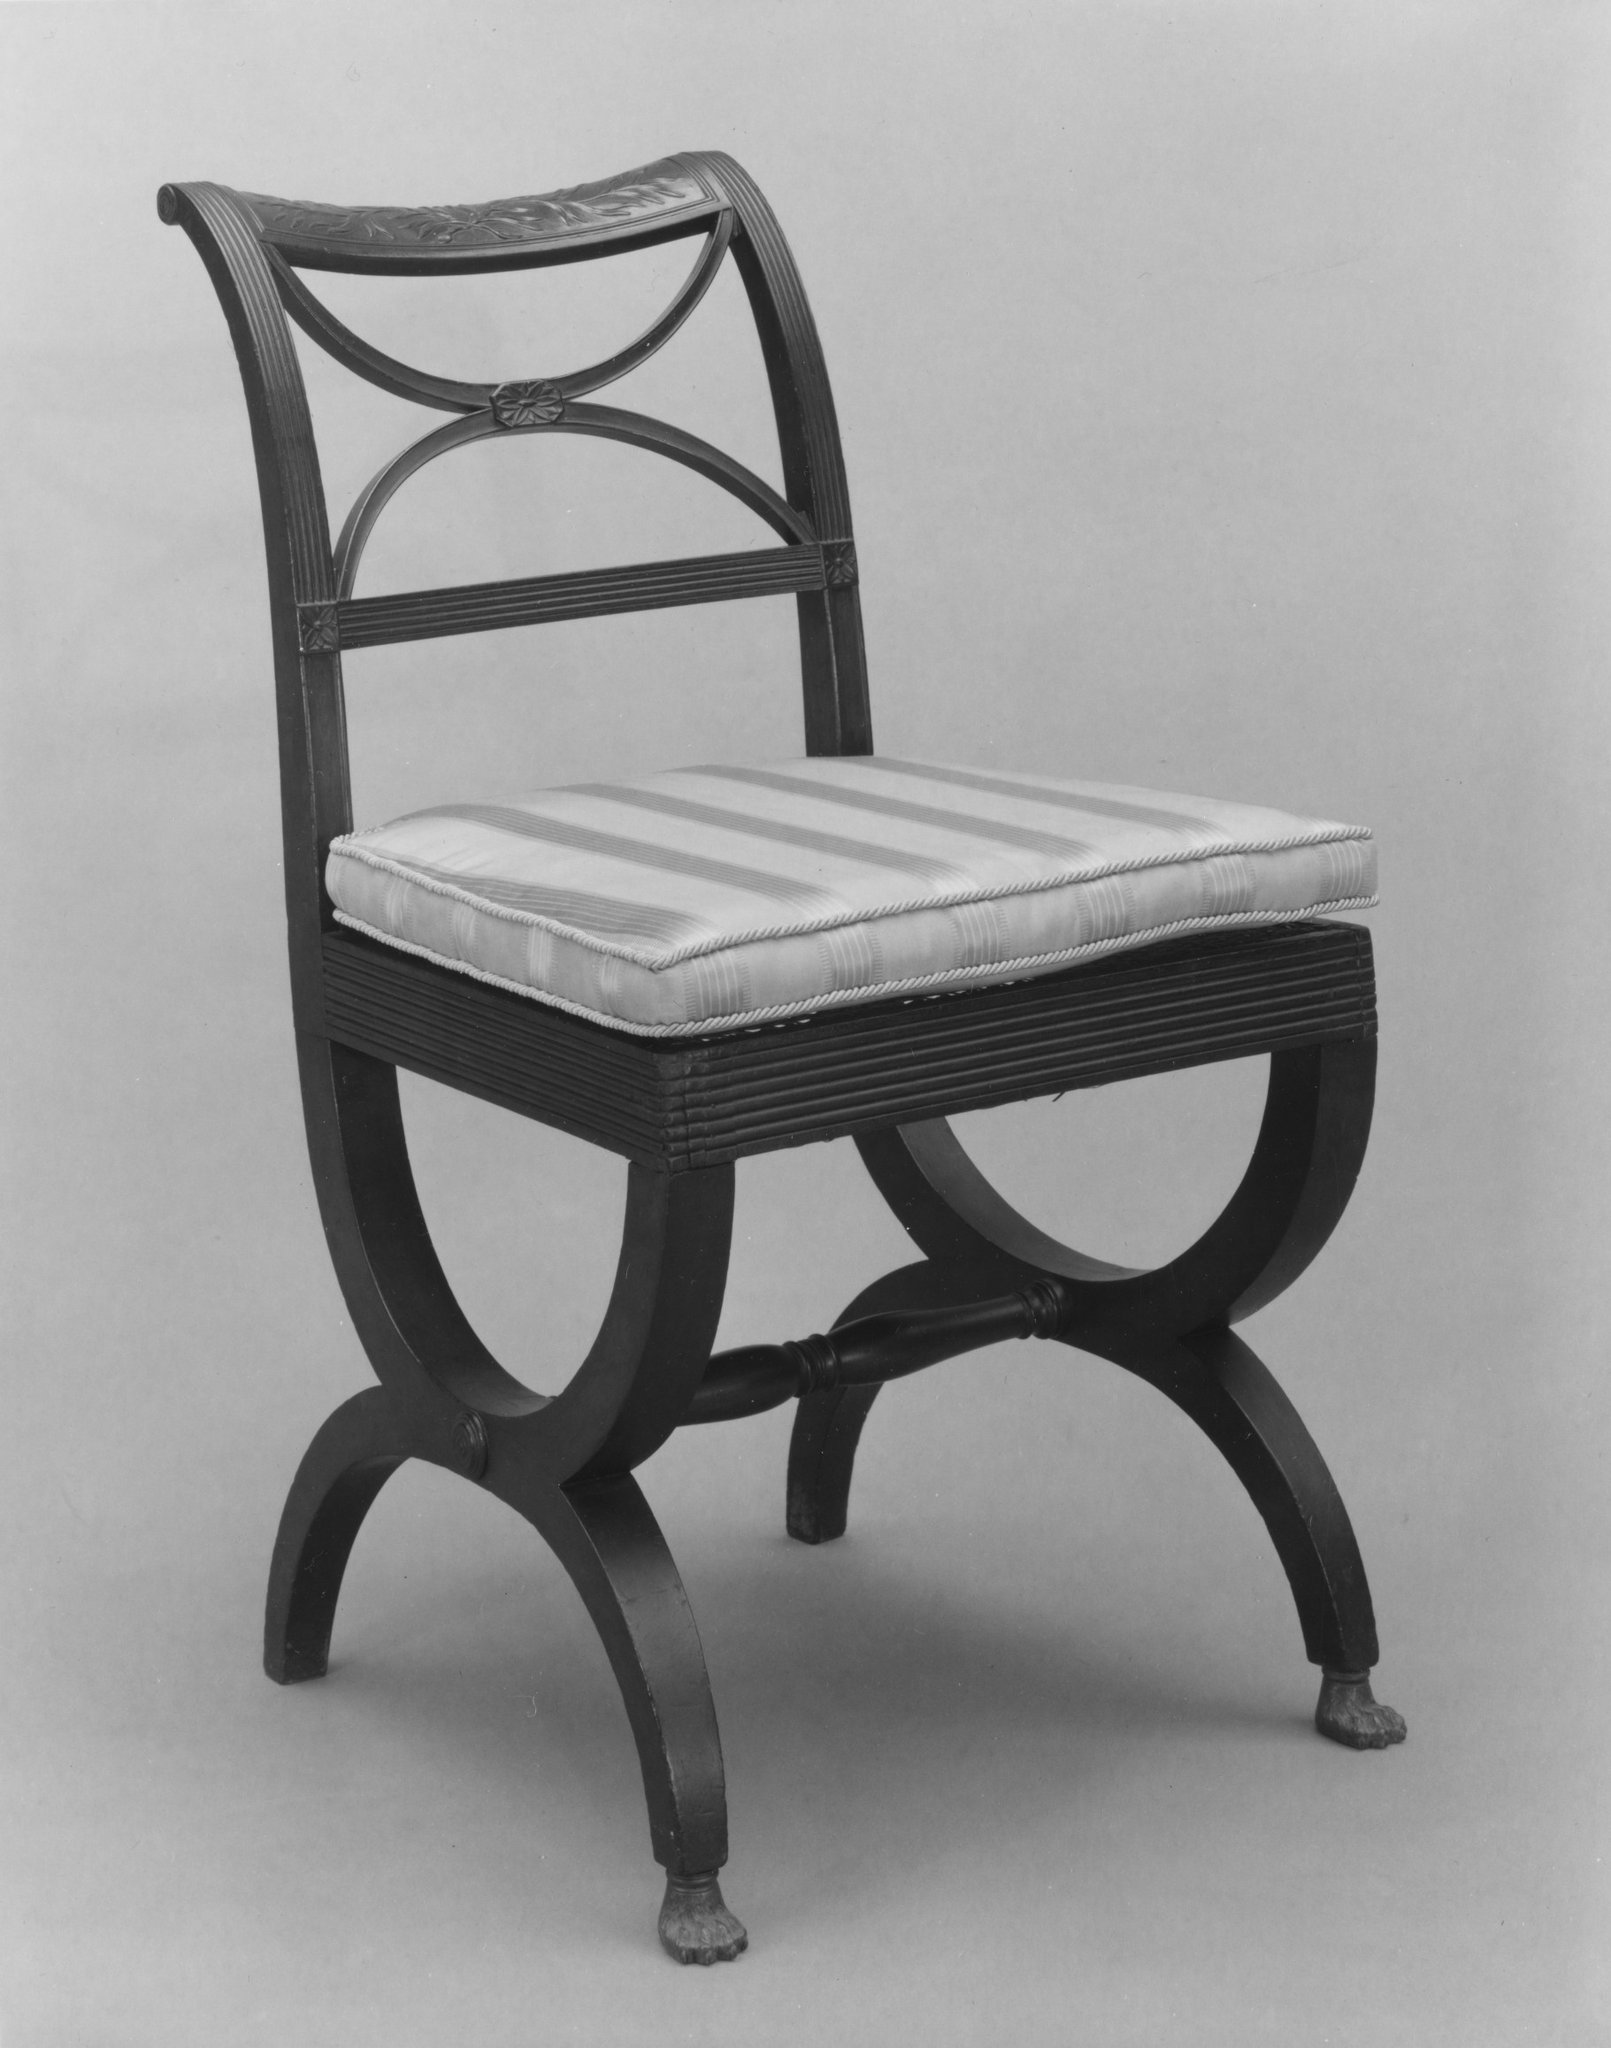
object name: side chair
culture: american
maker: duncan phyfe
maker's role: maker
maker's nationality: american, born scotland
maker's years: 1770-1854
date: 1791-1818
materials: brass, wood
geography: united states